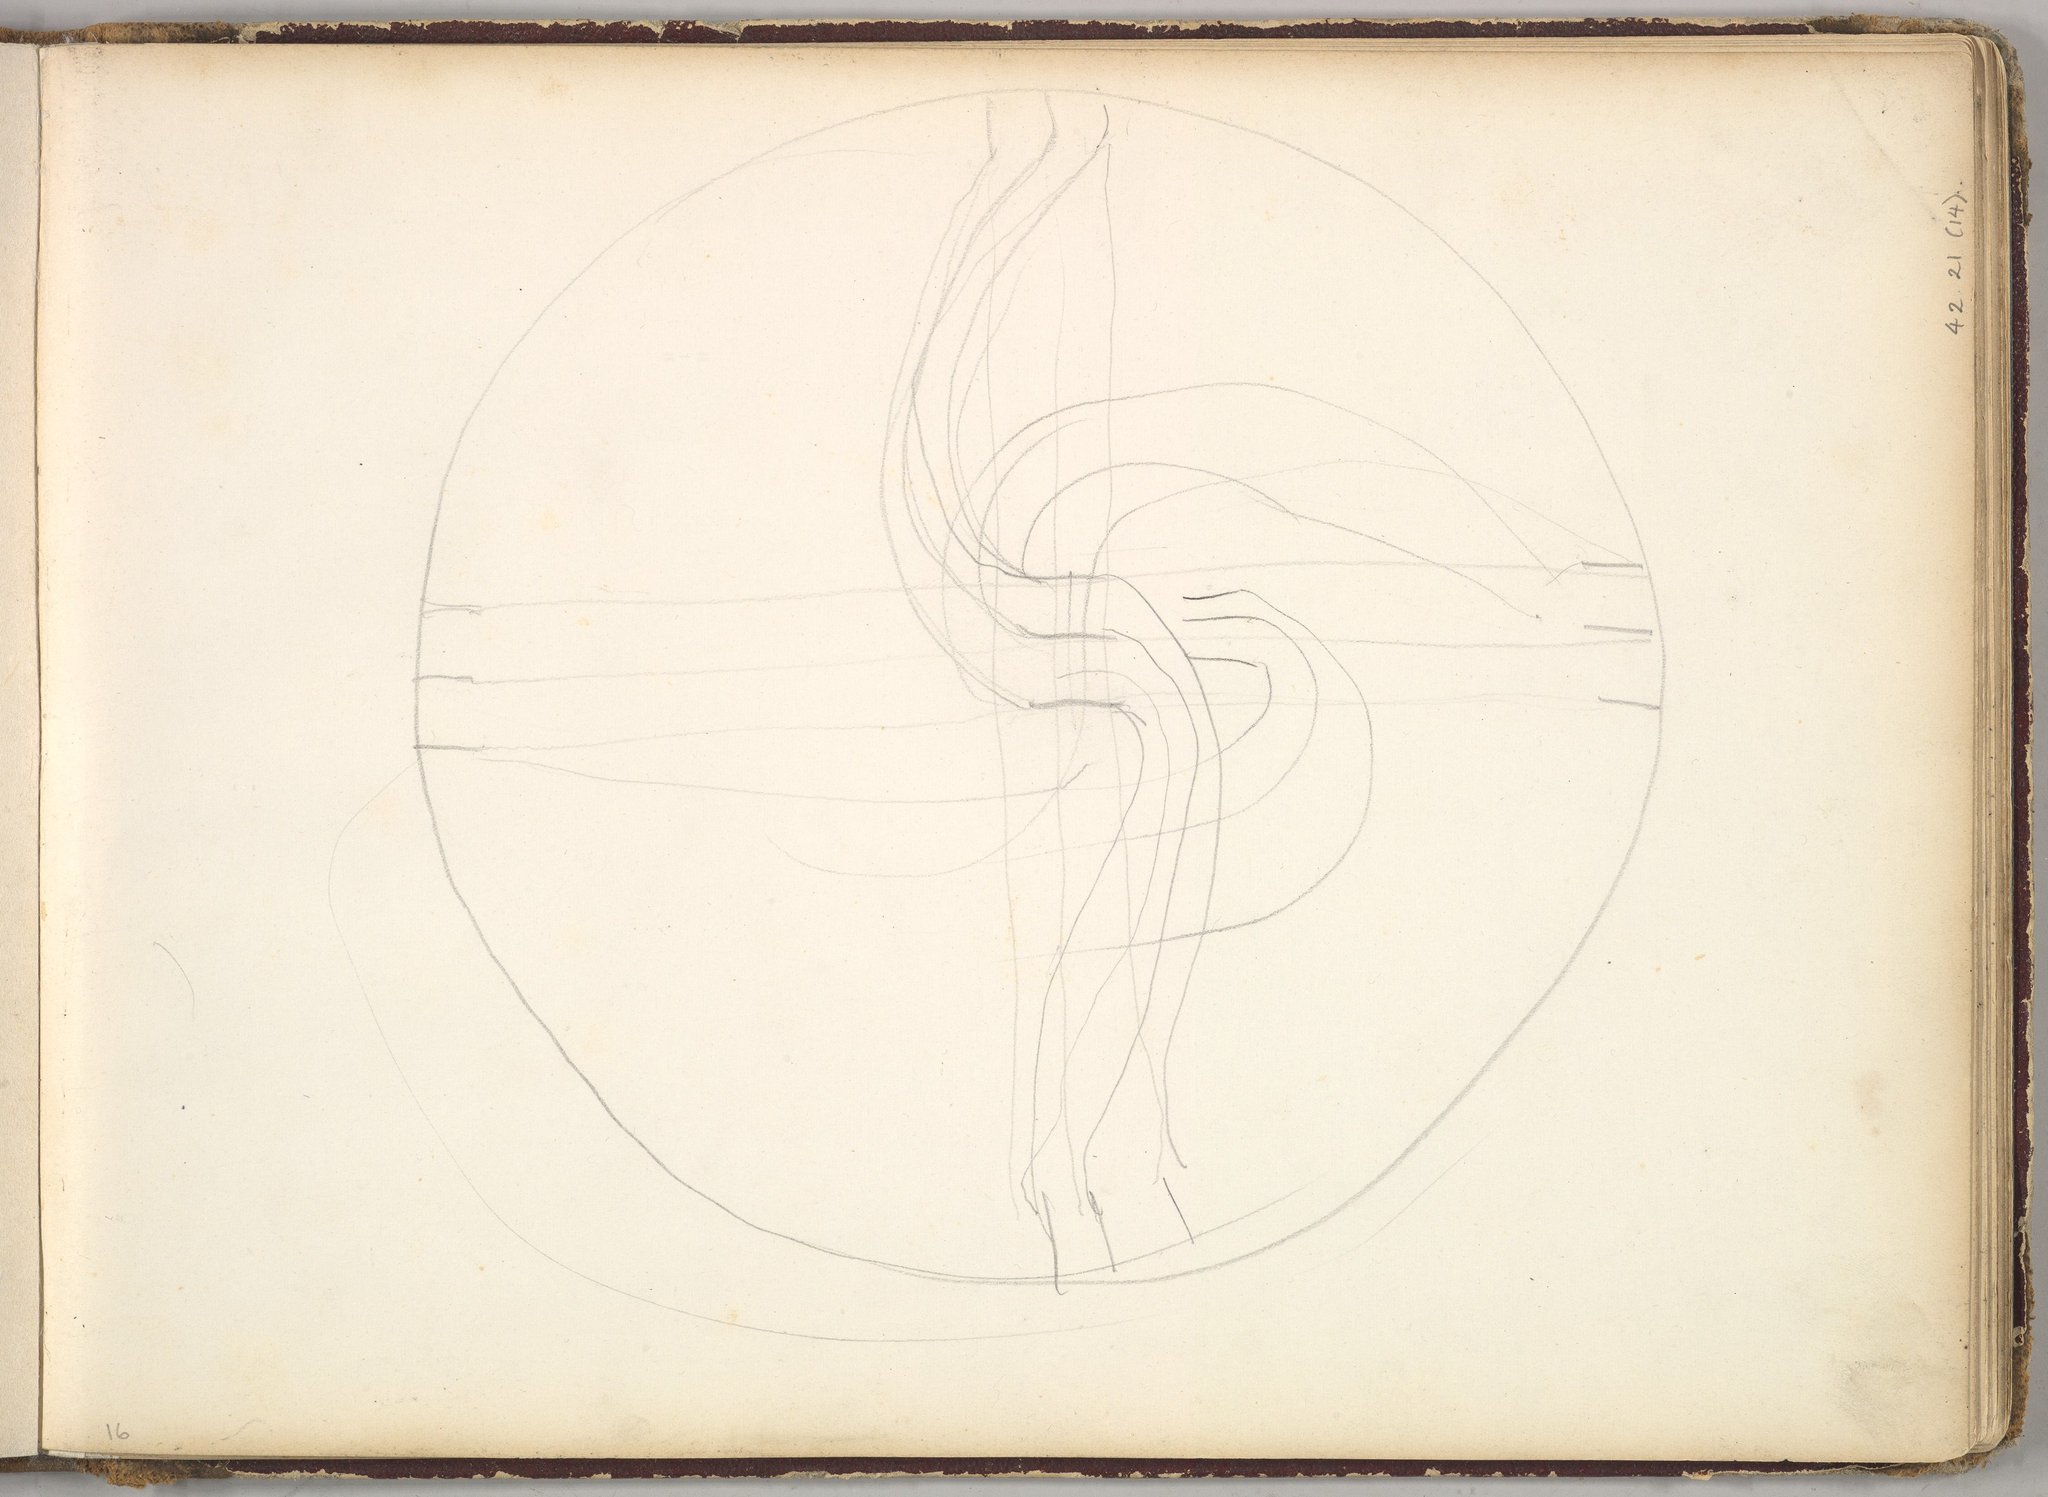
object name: drawing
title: Circular Diagram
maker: frederic, lord leighton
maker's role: artist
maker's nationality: british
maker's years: 1830-1896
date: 1849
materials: graphite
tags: abstraction